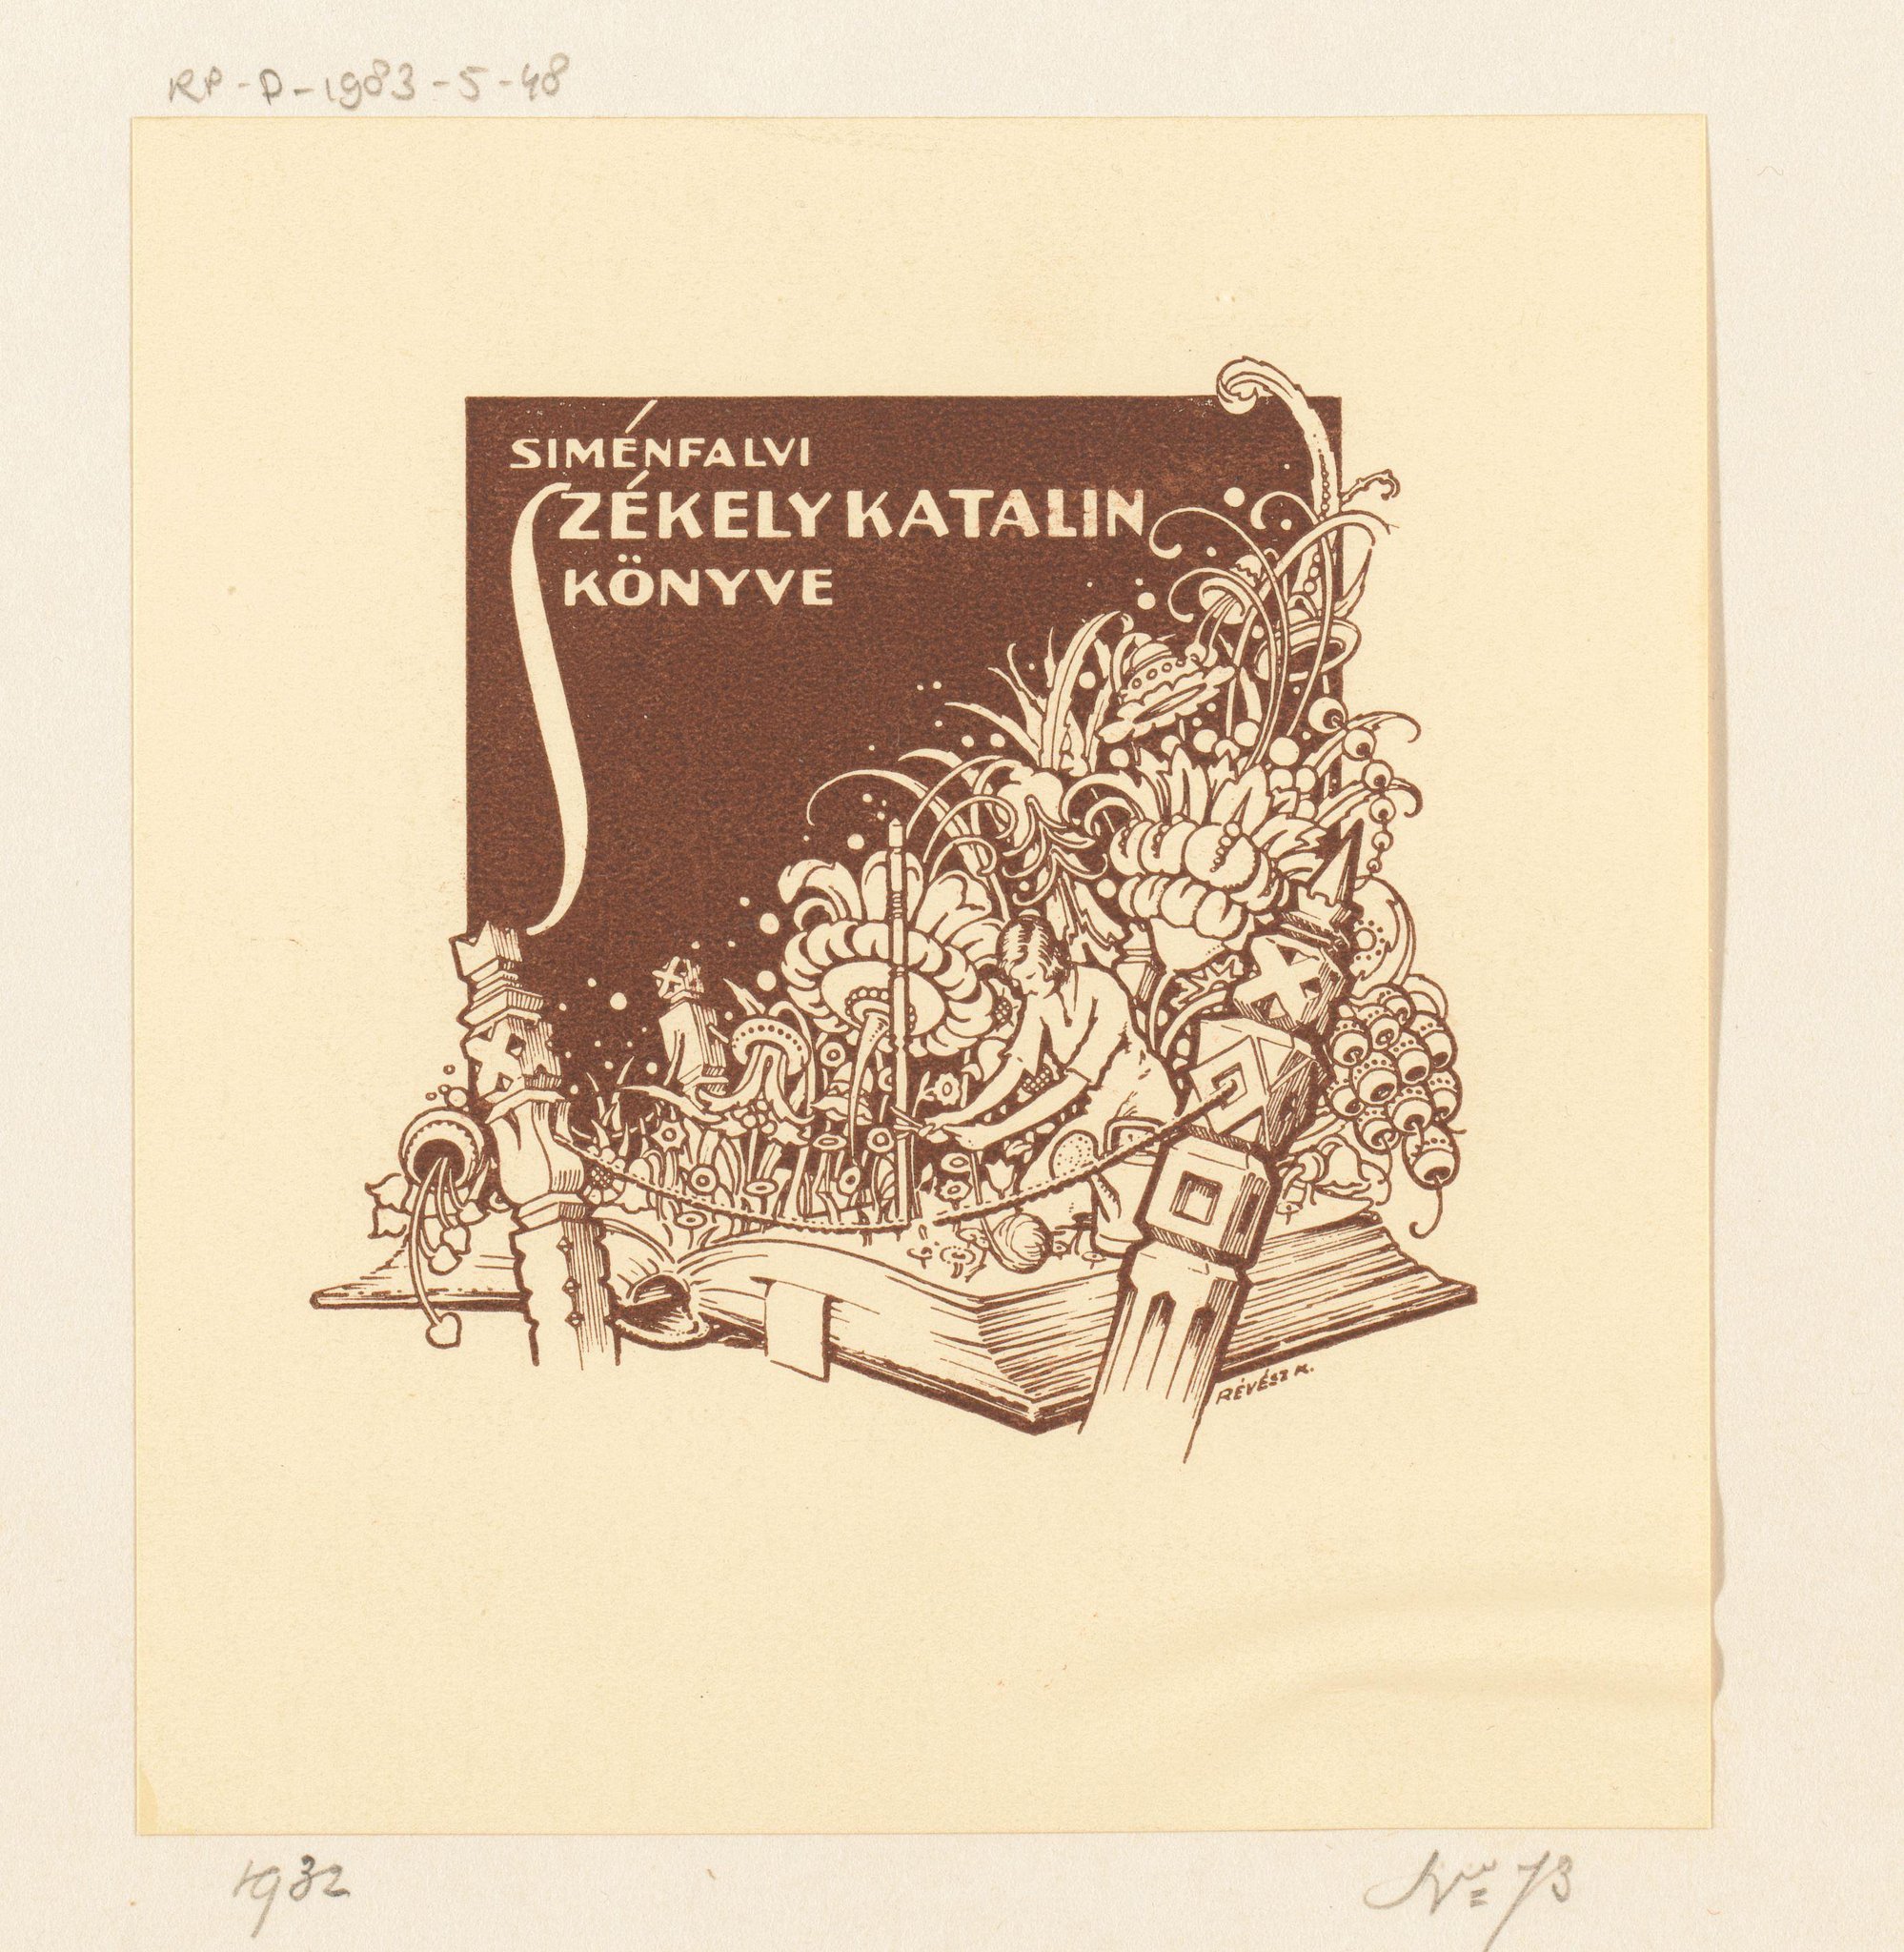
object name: bookplate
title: Ex libris van Katalin Székely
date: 1932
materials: paper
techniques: printing block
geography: budapest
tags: fantastic plants, fabulous vegetation, book, gardening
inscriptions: inscription: ‘1932/ No. 73’, workshop stamp: ‘Fecit/ Révész Kornél/ Budapest’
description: Ex libris maakt deel uit van omslag met 64 ex libris op 34 losse opzetvellen, een catalogus en een tekstblad.